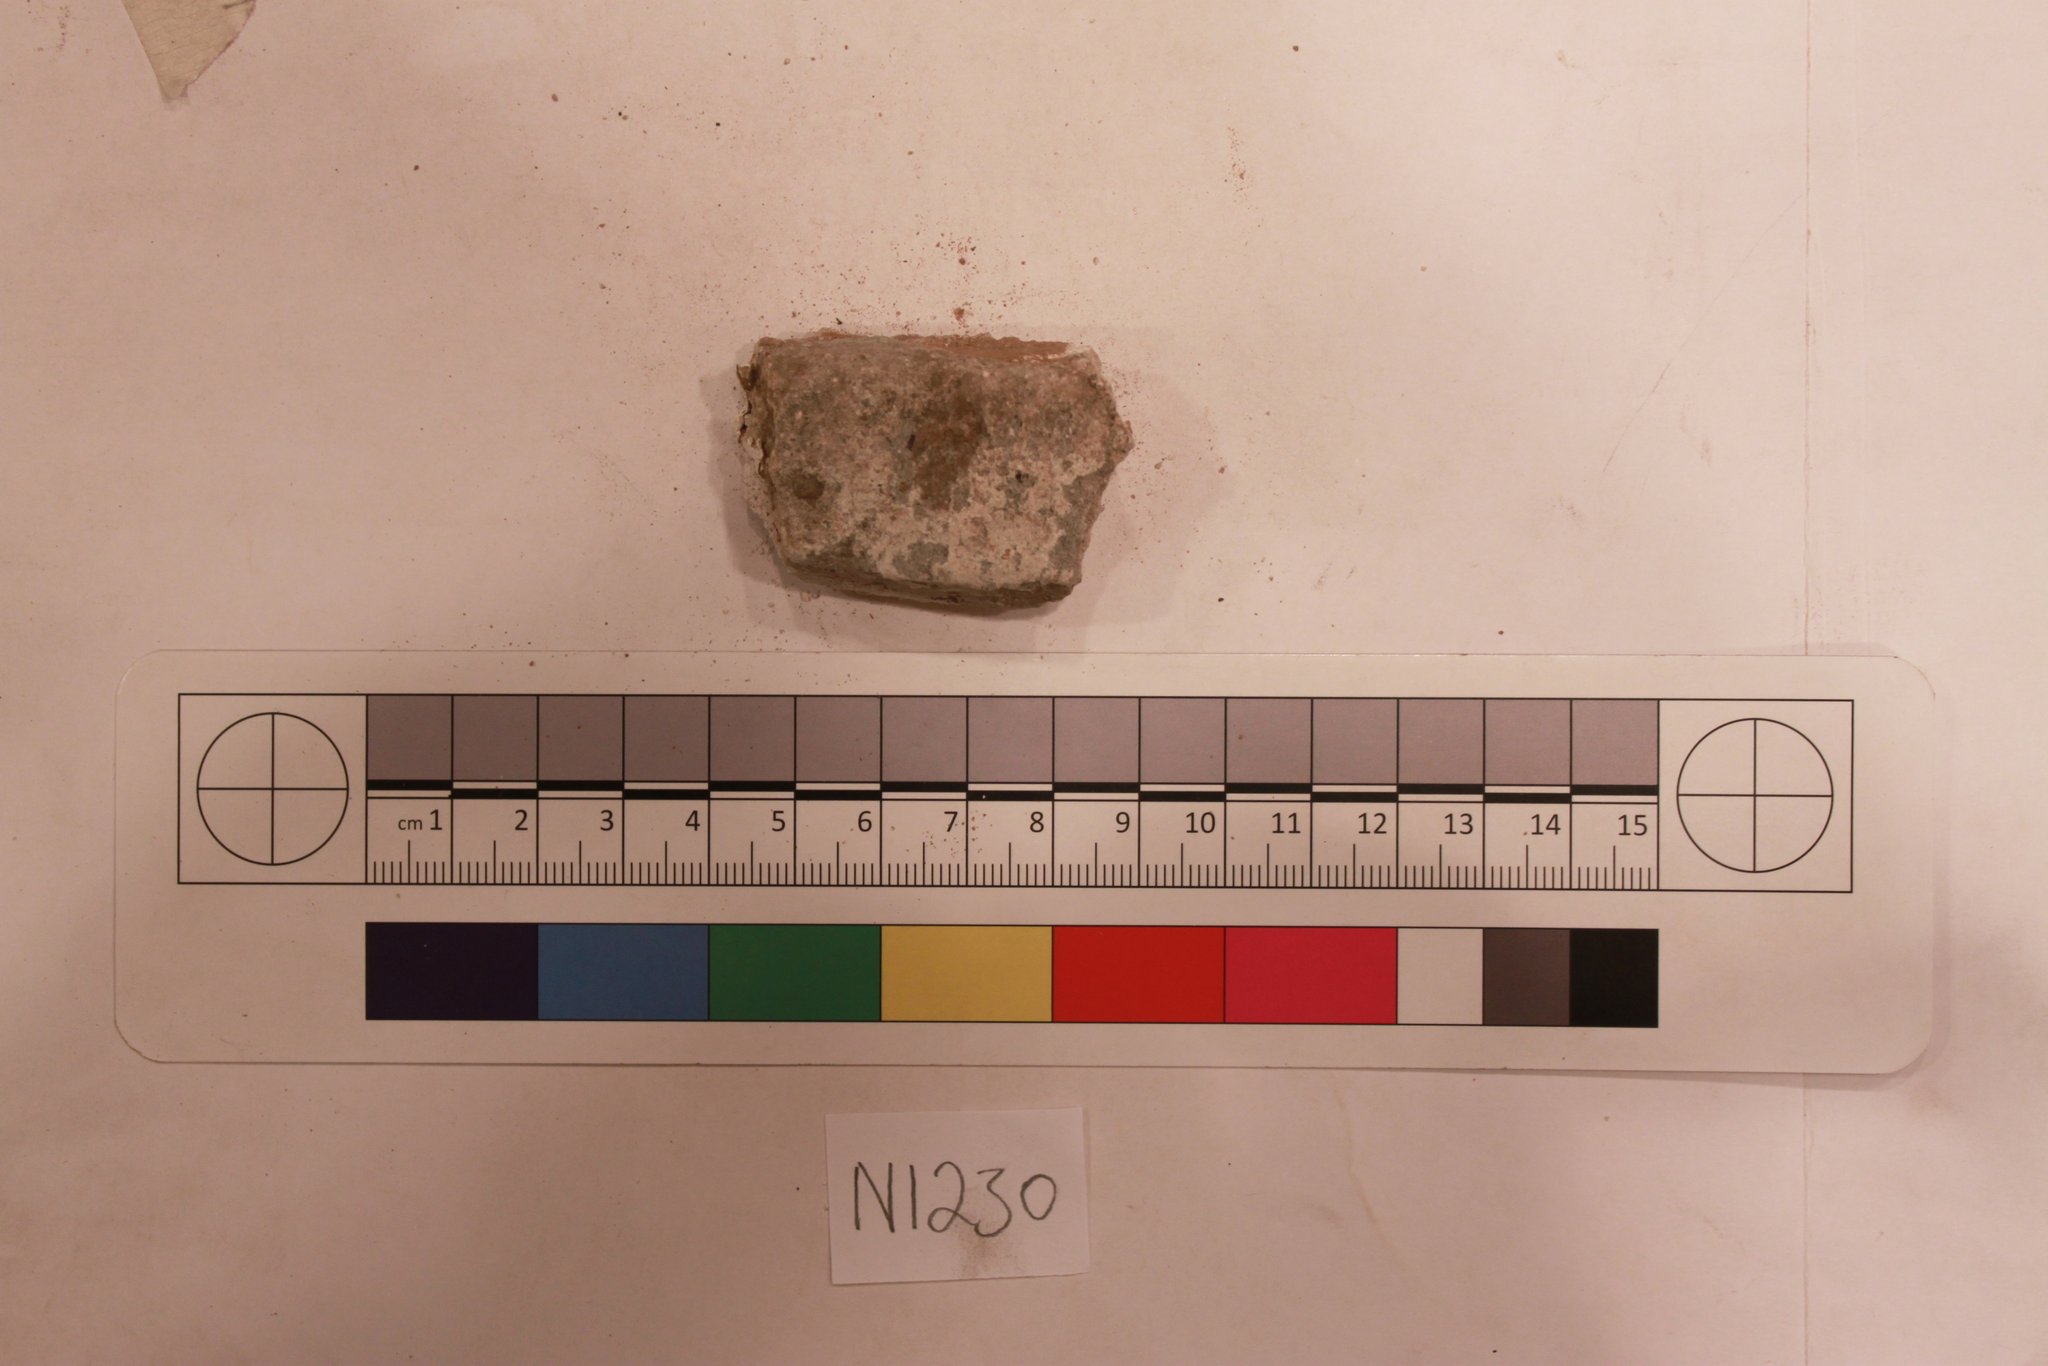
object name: fragment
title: Stucco Fragment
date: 701-1200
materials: plaster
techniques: carving, painting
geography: iran